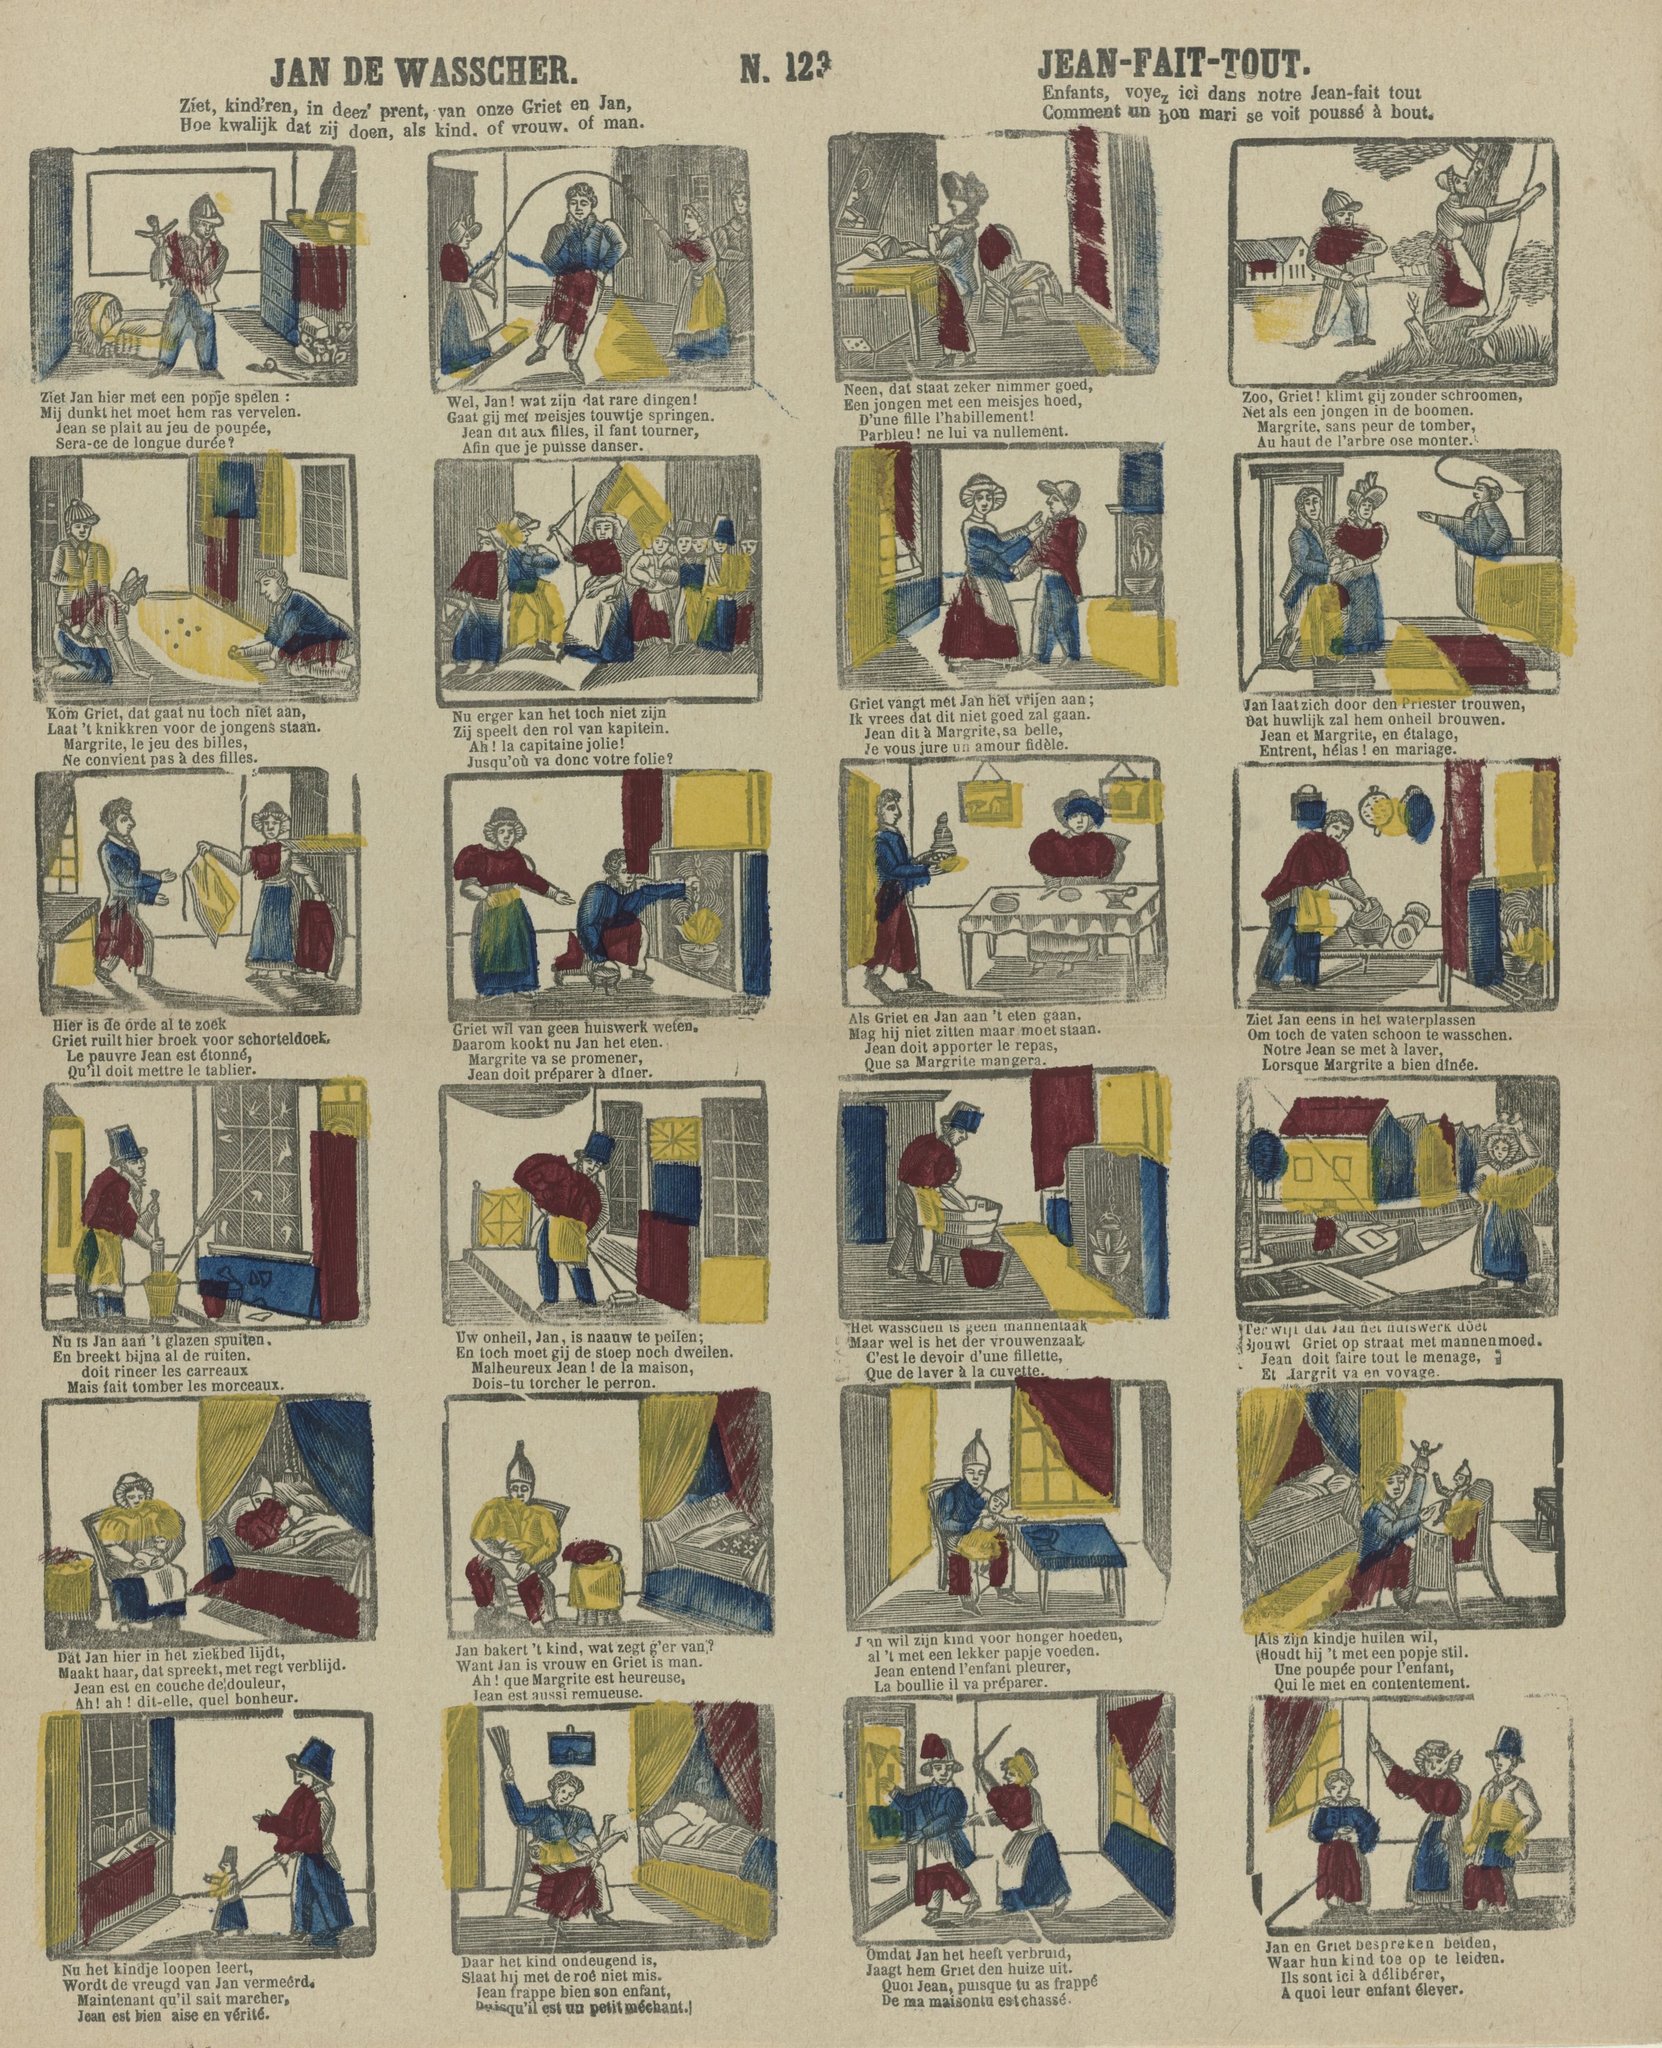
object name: popular print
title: Jan de Wasscher / Jean-fait-tout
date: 1800-1833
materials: paper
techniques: colour, letterpress printing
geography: turnhout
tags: hen-pecked husband, 'betty', 'molly' (man who engages in women's work)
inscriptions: collector's mark: Lugt 2760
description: Blad met 24 voorstellingen uit het leven van Jan de Wasser, een man die van zijn vrouw Griet, die de broek aan heeft, al het huishoudelijk werk moet doen. Onder elke voorstelling een tweeregelig vers in het Nederlands en in het Frans. Genummerd midden boven: N. 123.